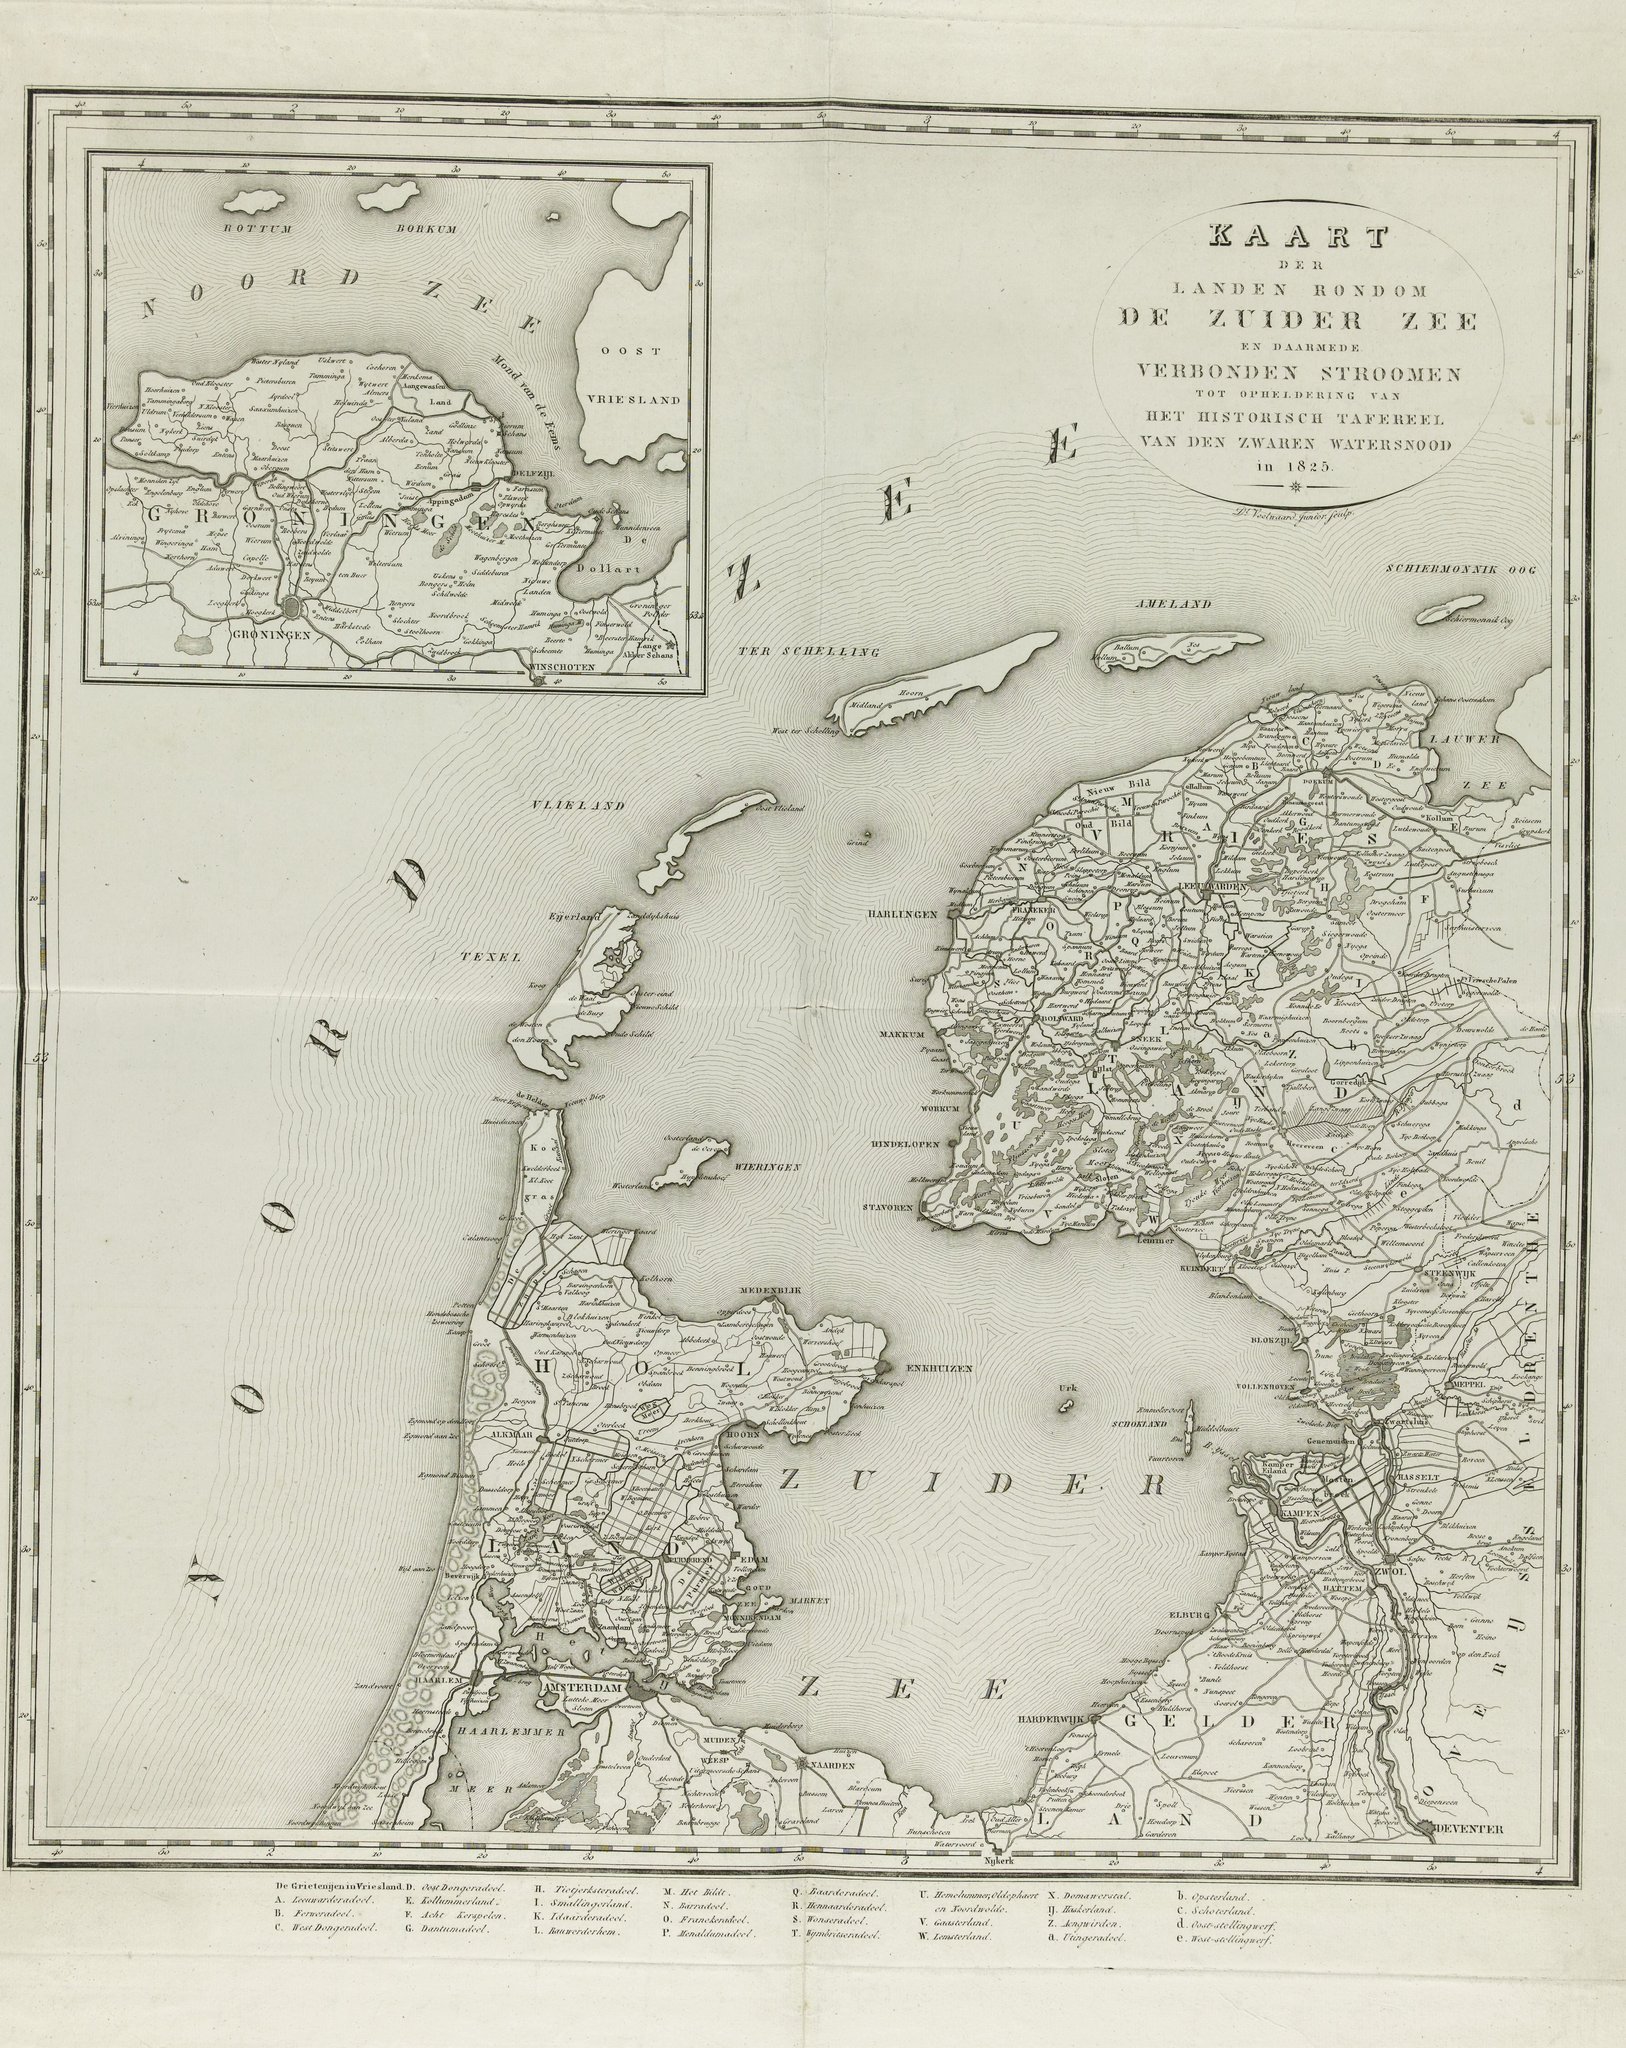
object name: map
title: Kaart der landen rondom de Zuider Zee en daarmede verbonden stroomen tot opheldering van het historisch tafereel van den zwaren watersnood in 1825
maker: daniël veelwaard (ii)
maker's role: print maker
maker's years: 1796-1868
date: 1825-1826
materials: paper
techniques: engraving, etching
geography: netherlands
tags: maps of separate countries or regions, flood, zuiderzee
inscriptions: collector's mark: Lugt 2228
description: Gebruikt als illustratie in: Nicolaas Swart, Historisch tafereel van den zwaren watersnood, op den 3den, 4den en 5den Februarij 1825, een groot deel van ons vaderland hebbende getroffen. Amsterdam : bij Schalekamp en Van de Grampel, 1826.